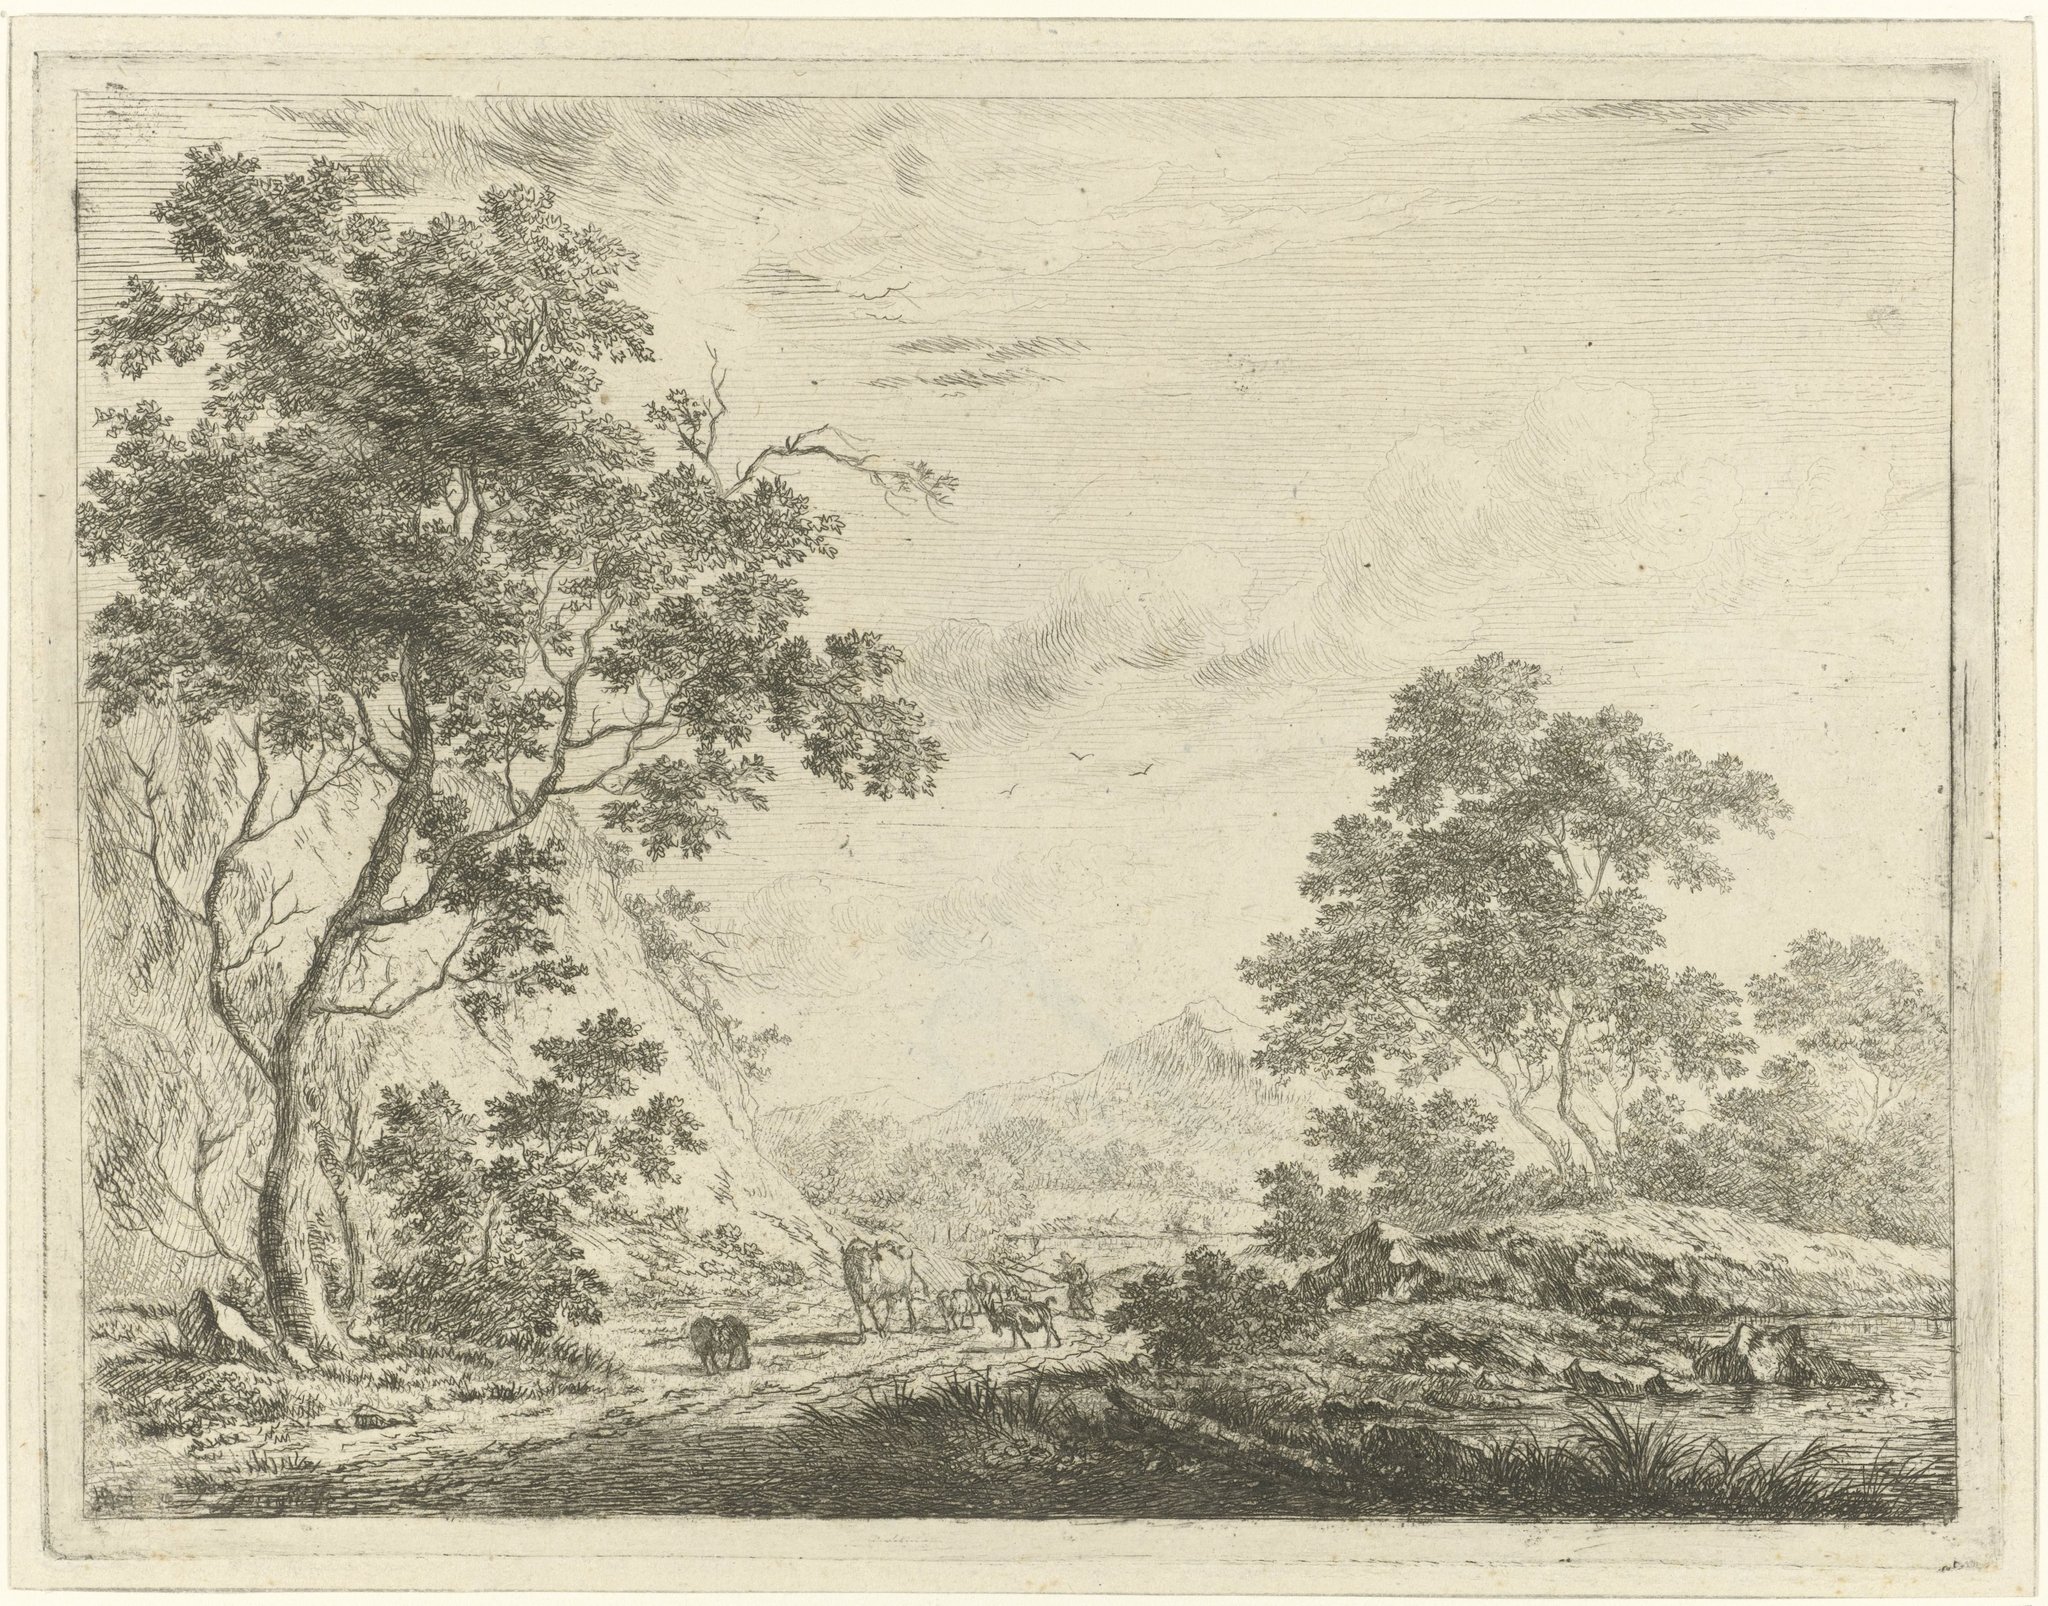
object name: print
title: Landschap met herder en vee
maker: johannes janson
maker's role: draughtsman, painter, print maker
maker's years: 1729-1784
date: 1761-1784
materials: paper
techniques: etching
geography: leiden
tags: landscapes (+ landscape with figures, staffage)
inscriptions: collector's mark: Lugt 2228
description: Landschap met een herder die zijn vee over een pad langs een berg drijft. Rechts een meer. Prent uit een serie met landschappen met herders en vee.